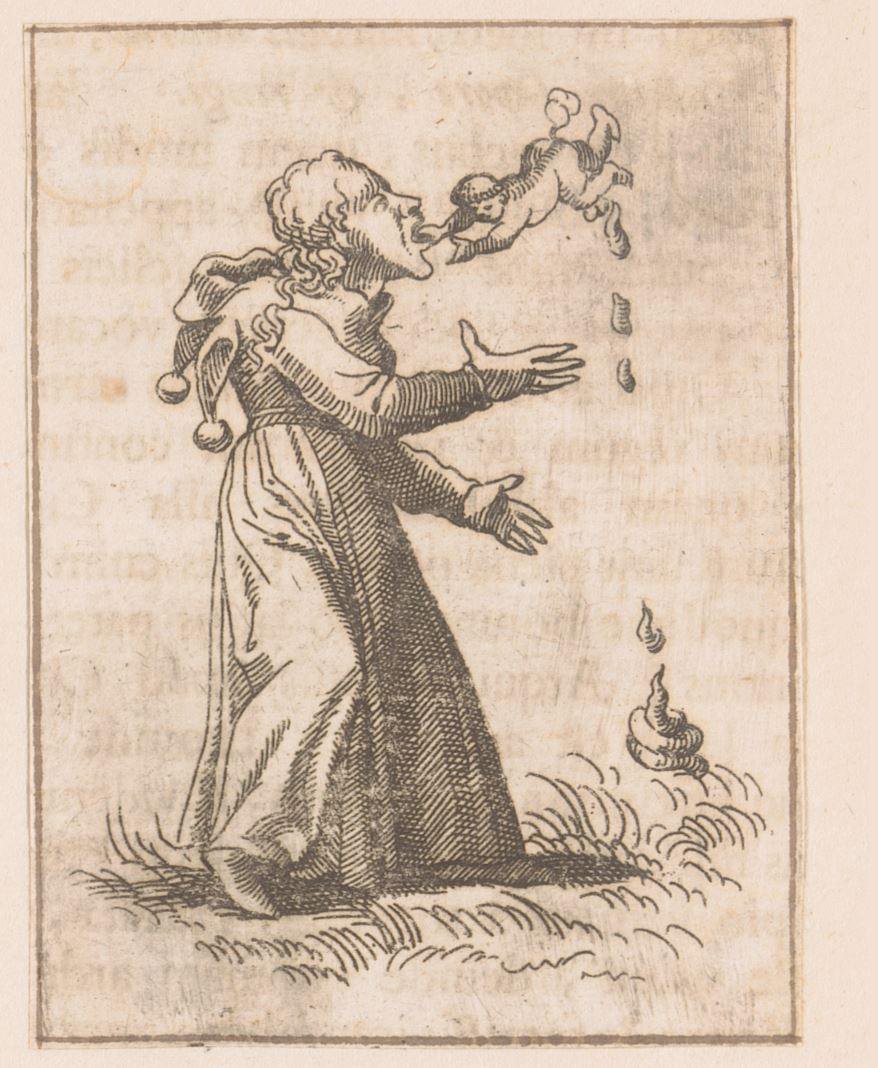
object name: book illustration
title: Dwaasheid staat op het punt de poepende ziel van Johannes Duns Scotus in te slikken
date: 1516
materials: paper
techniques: etching, letterpress printing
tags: desiderius erasmus, court jester, court fool, folly, foolishness; 'pazzia', 'sciocchezza', 'stoltitia' (ripa), the soul, defecation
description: Prent afkomstig uit: Erasmus, Desiderius. Morias enkomion (...). Bazel: Johann Rudolf Genath, 1676. De prenten hierin zijn naar tekeningen die Hans en Ambrosius Holbein maakten voor de theoloog Oswald Myconius in diens uitgave van de Moriae encomium (Lof der Zotheid) van 1516.